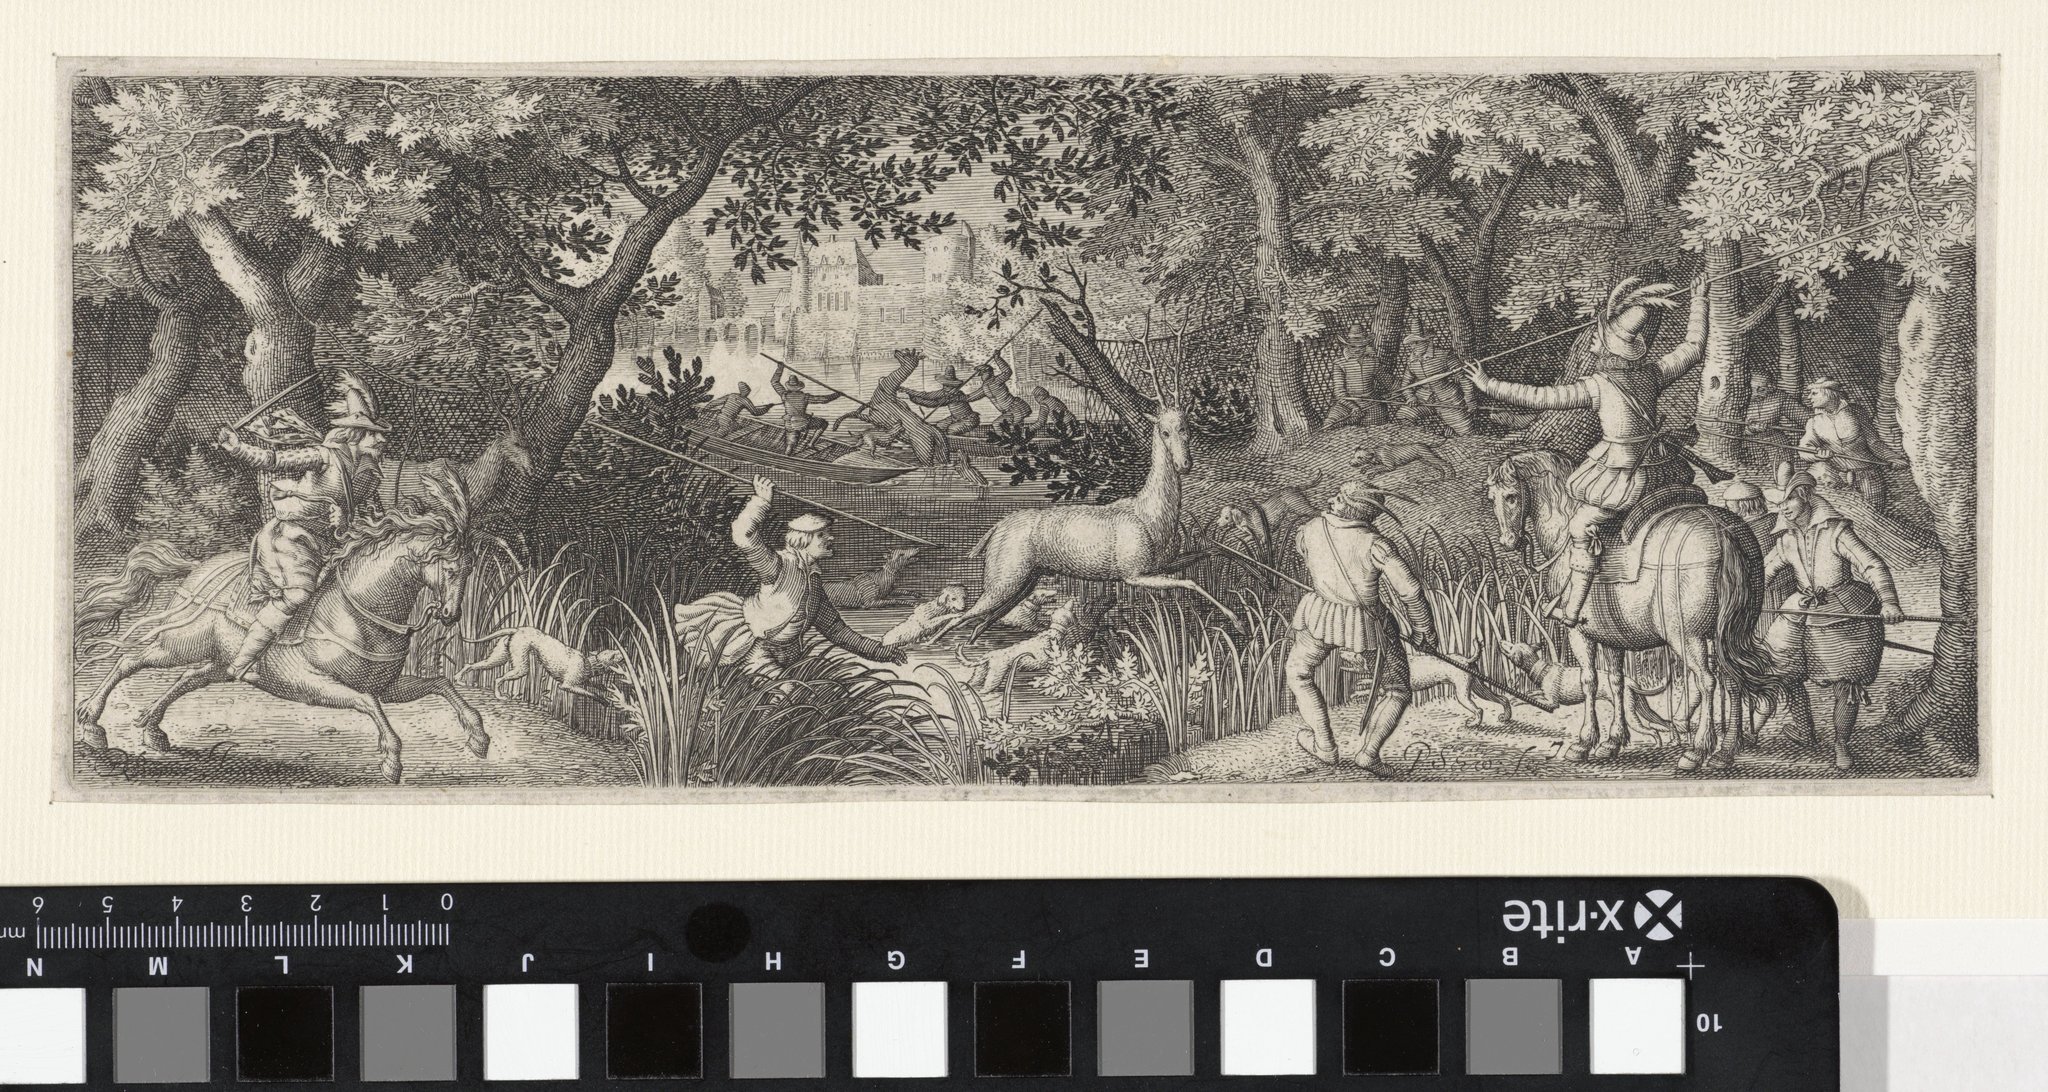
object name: print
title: Jachttaferelen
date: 1612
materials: paper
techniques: engraving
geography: amsterdam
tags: hunting, chase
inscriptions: collector's mark: Lugt 2228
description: Twee mannen te paard worden door voetvolk en honden geassisteerd bij het jagen op herten. Vanaf twee roeibootjes wordt een hert gespietst dat het water ingevlucht is. Op de achtergrond een kasteel aan het water.